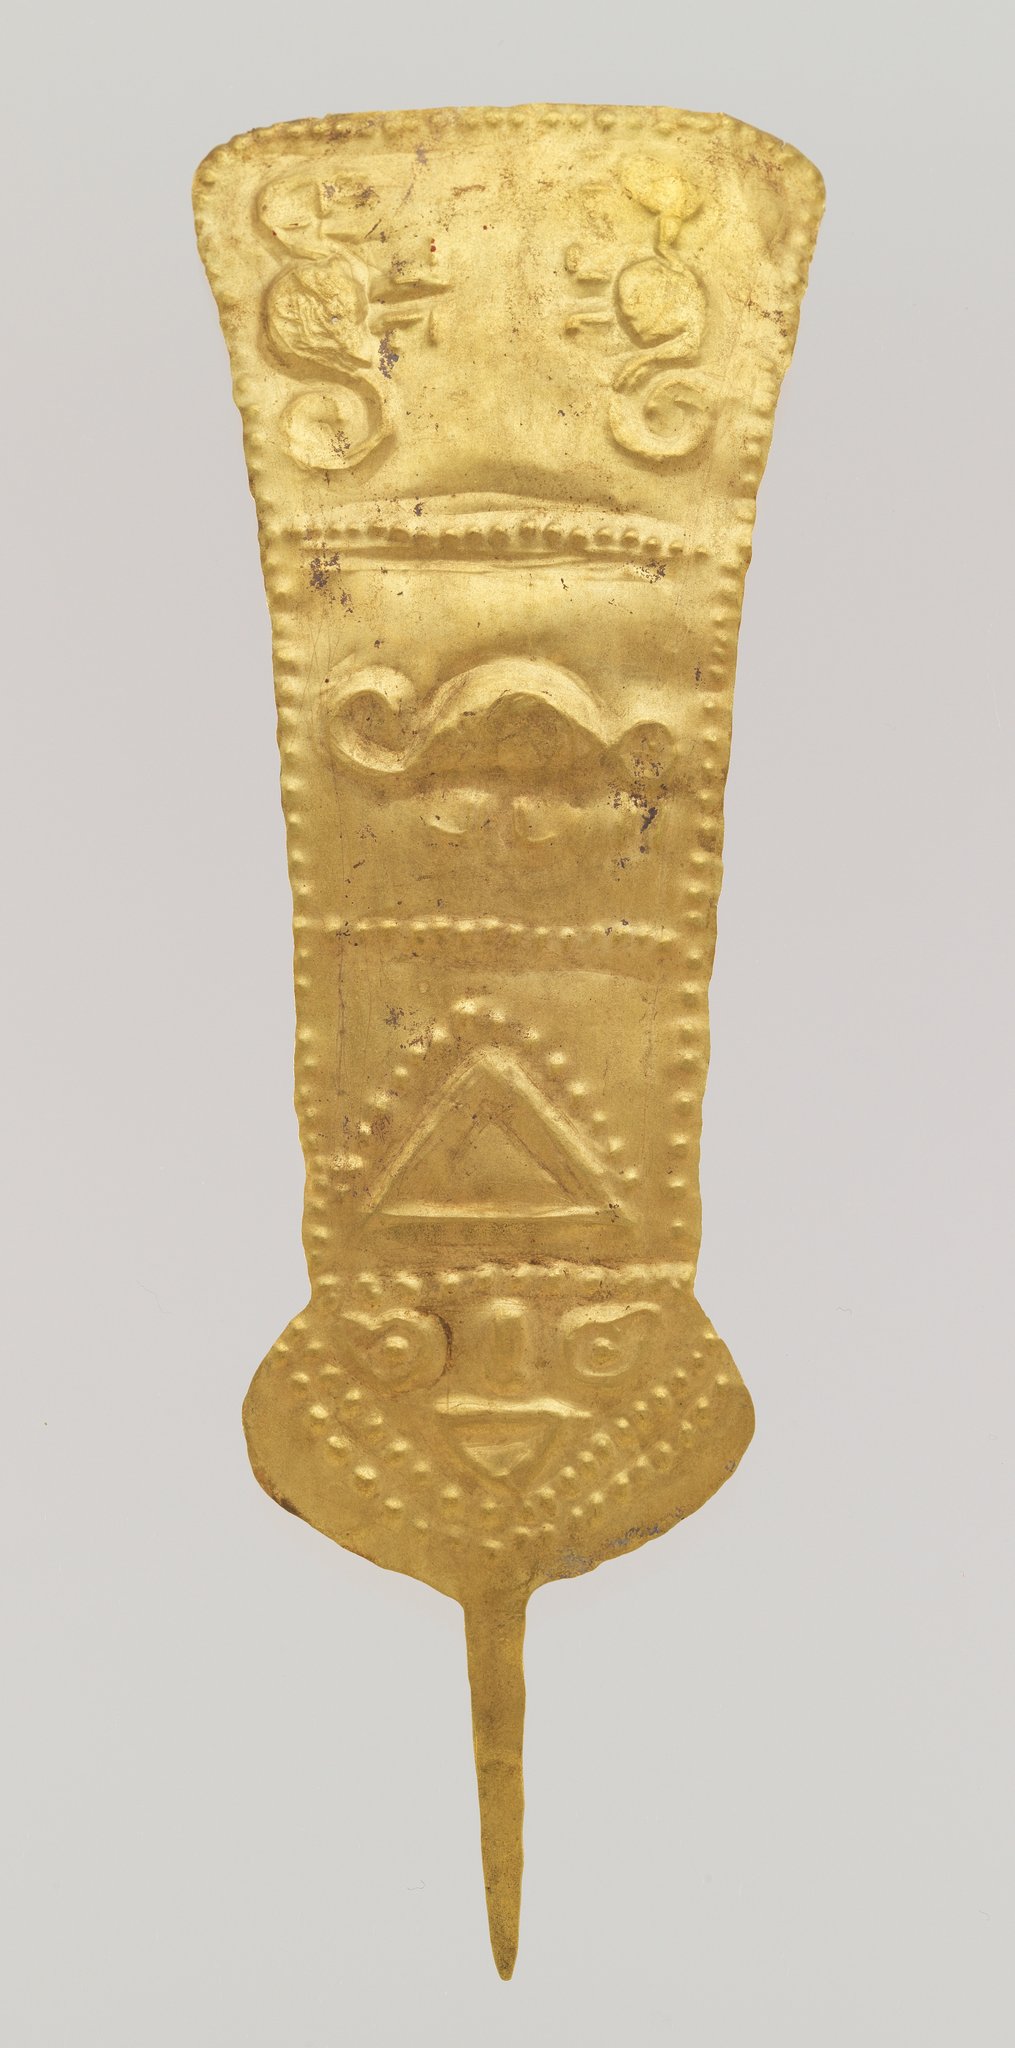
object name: ornament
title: Plume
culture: lambayeque, sicán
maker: lambayeque (sicán) artist(s)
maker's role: artist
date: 900-1375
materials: gold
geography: peru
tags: animals